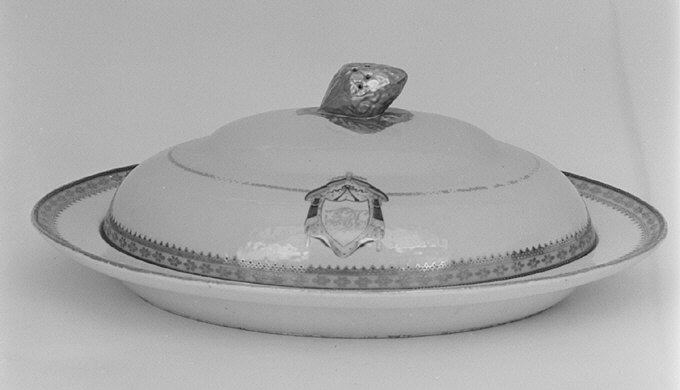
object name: dish with cover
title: Deep dish with cover (part of a service)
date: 1790-1800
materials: hard paste porcelain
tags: coat of arms